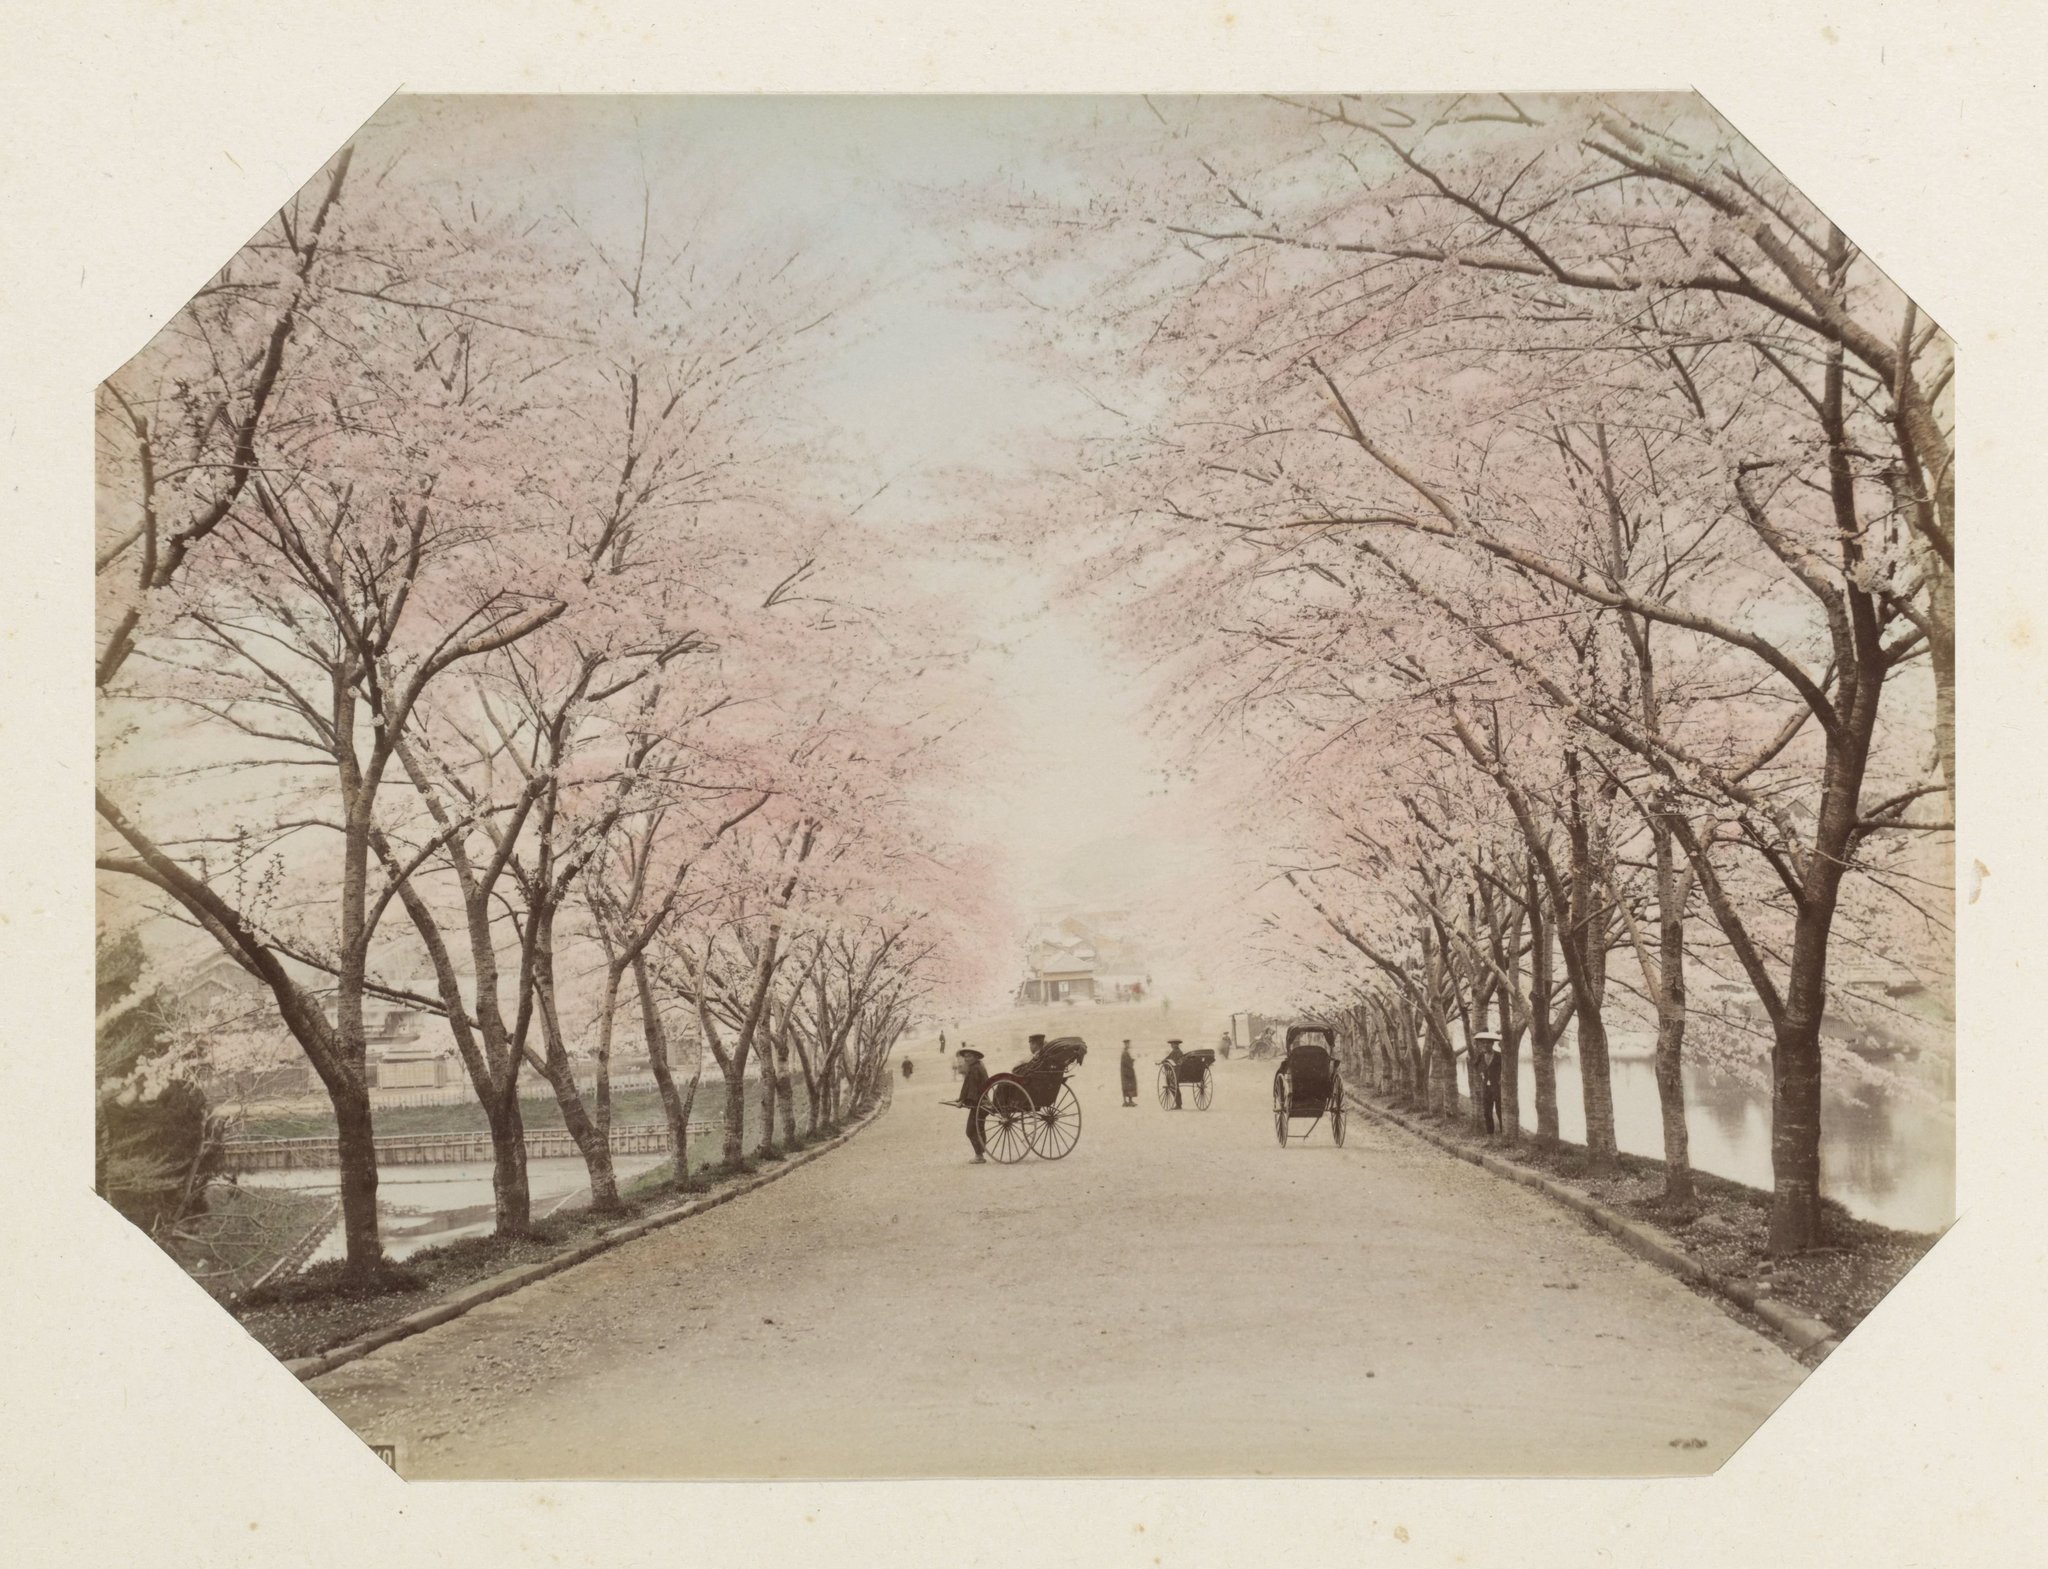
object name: photograph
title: Akasaka, Tokyo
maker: Anonymous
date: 1870-1900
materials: paint, photographic support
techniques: albumen print, hand coloring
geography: tokyo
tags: rickshaw, forest path or lane, trees (+ flowers, blossom, blossoming)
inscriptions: number: ‘B 2’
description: Onderdeel van Fotoalbum met opnames van bezienswaardigheden in Japan en studioportretten.